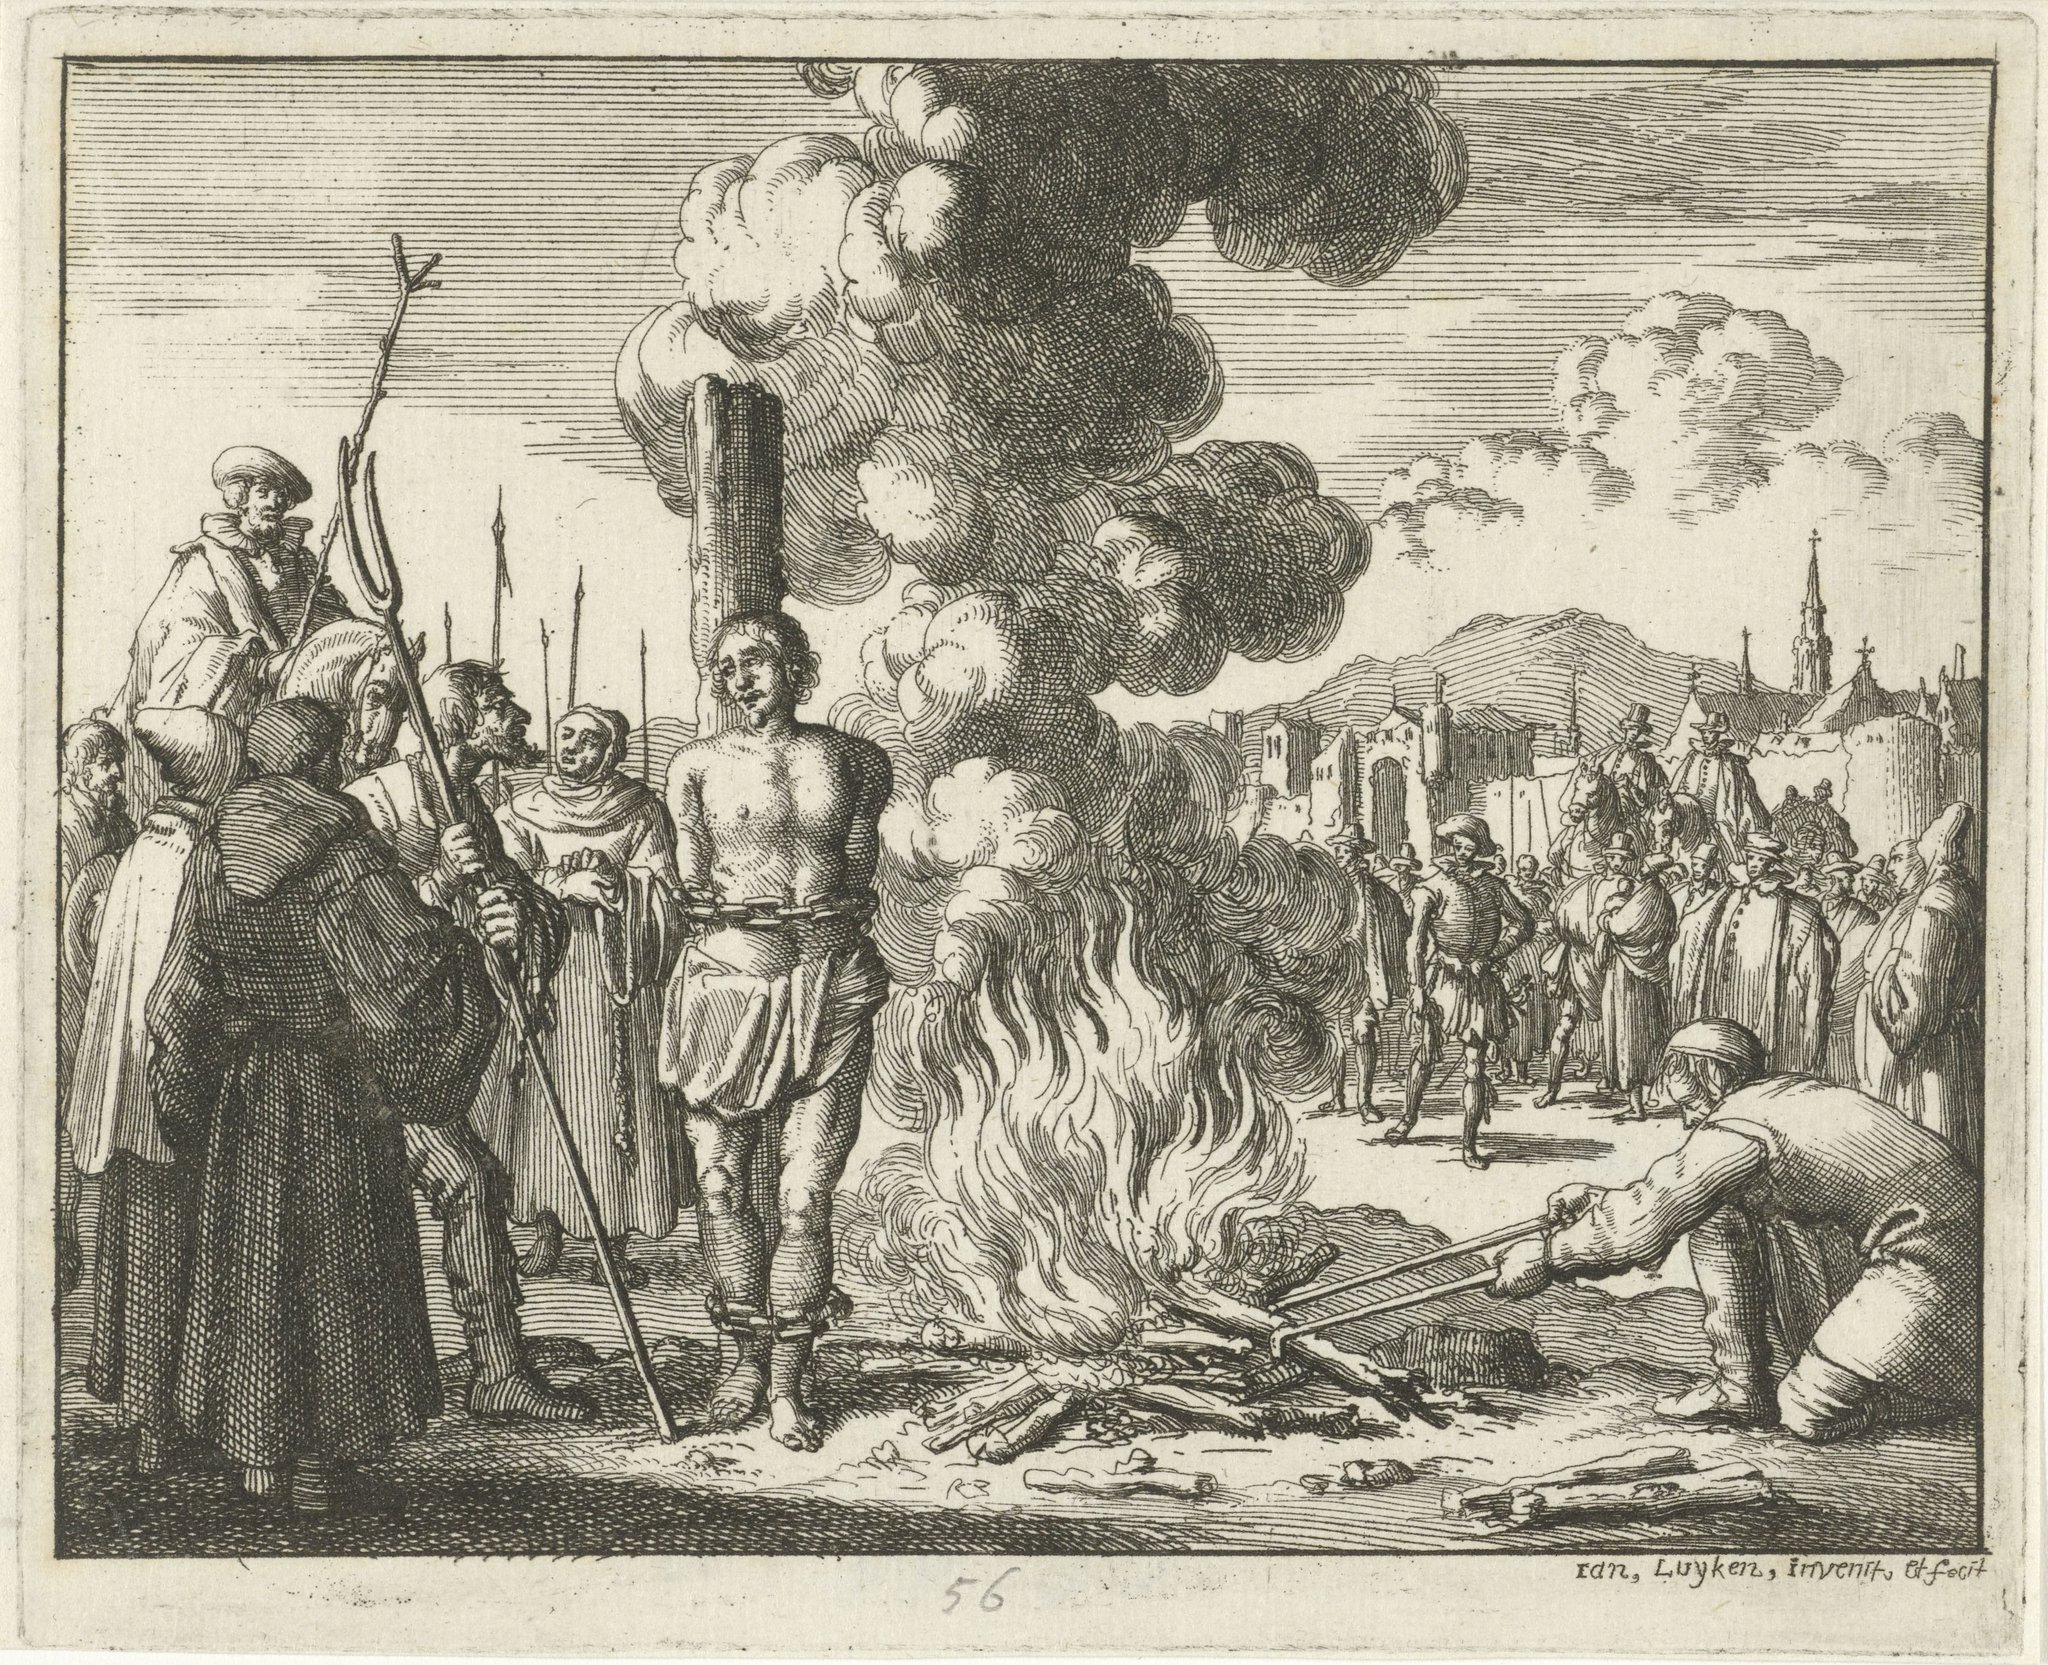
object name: book illustration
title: Leonhard Bernkopff voor de brandstapel, 1542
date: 1685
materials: paper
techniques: etching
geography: amsterdam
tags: execution of heretic, e.g. by burning at the stake, 'auto-da-fé'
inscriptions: collector's mark: Lugt 2228, number: ‘56’